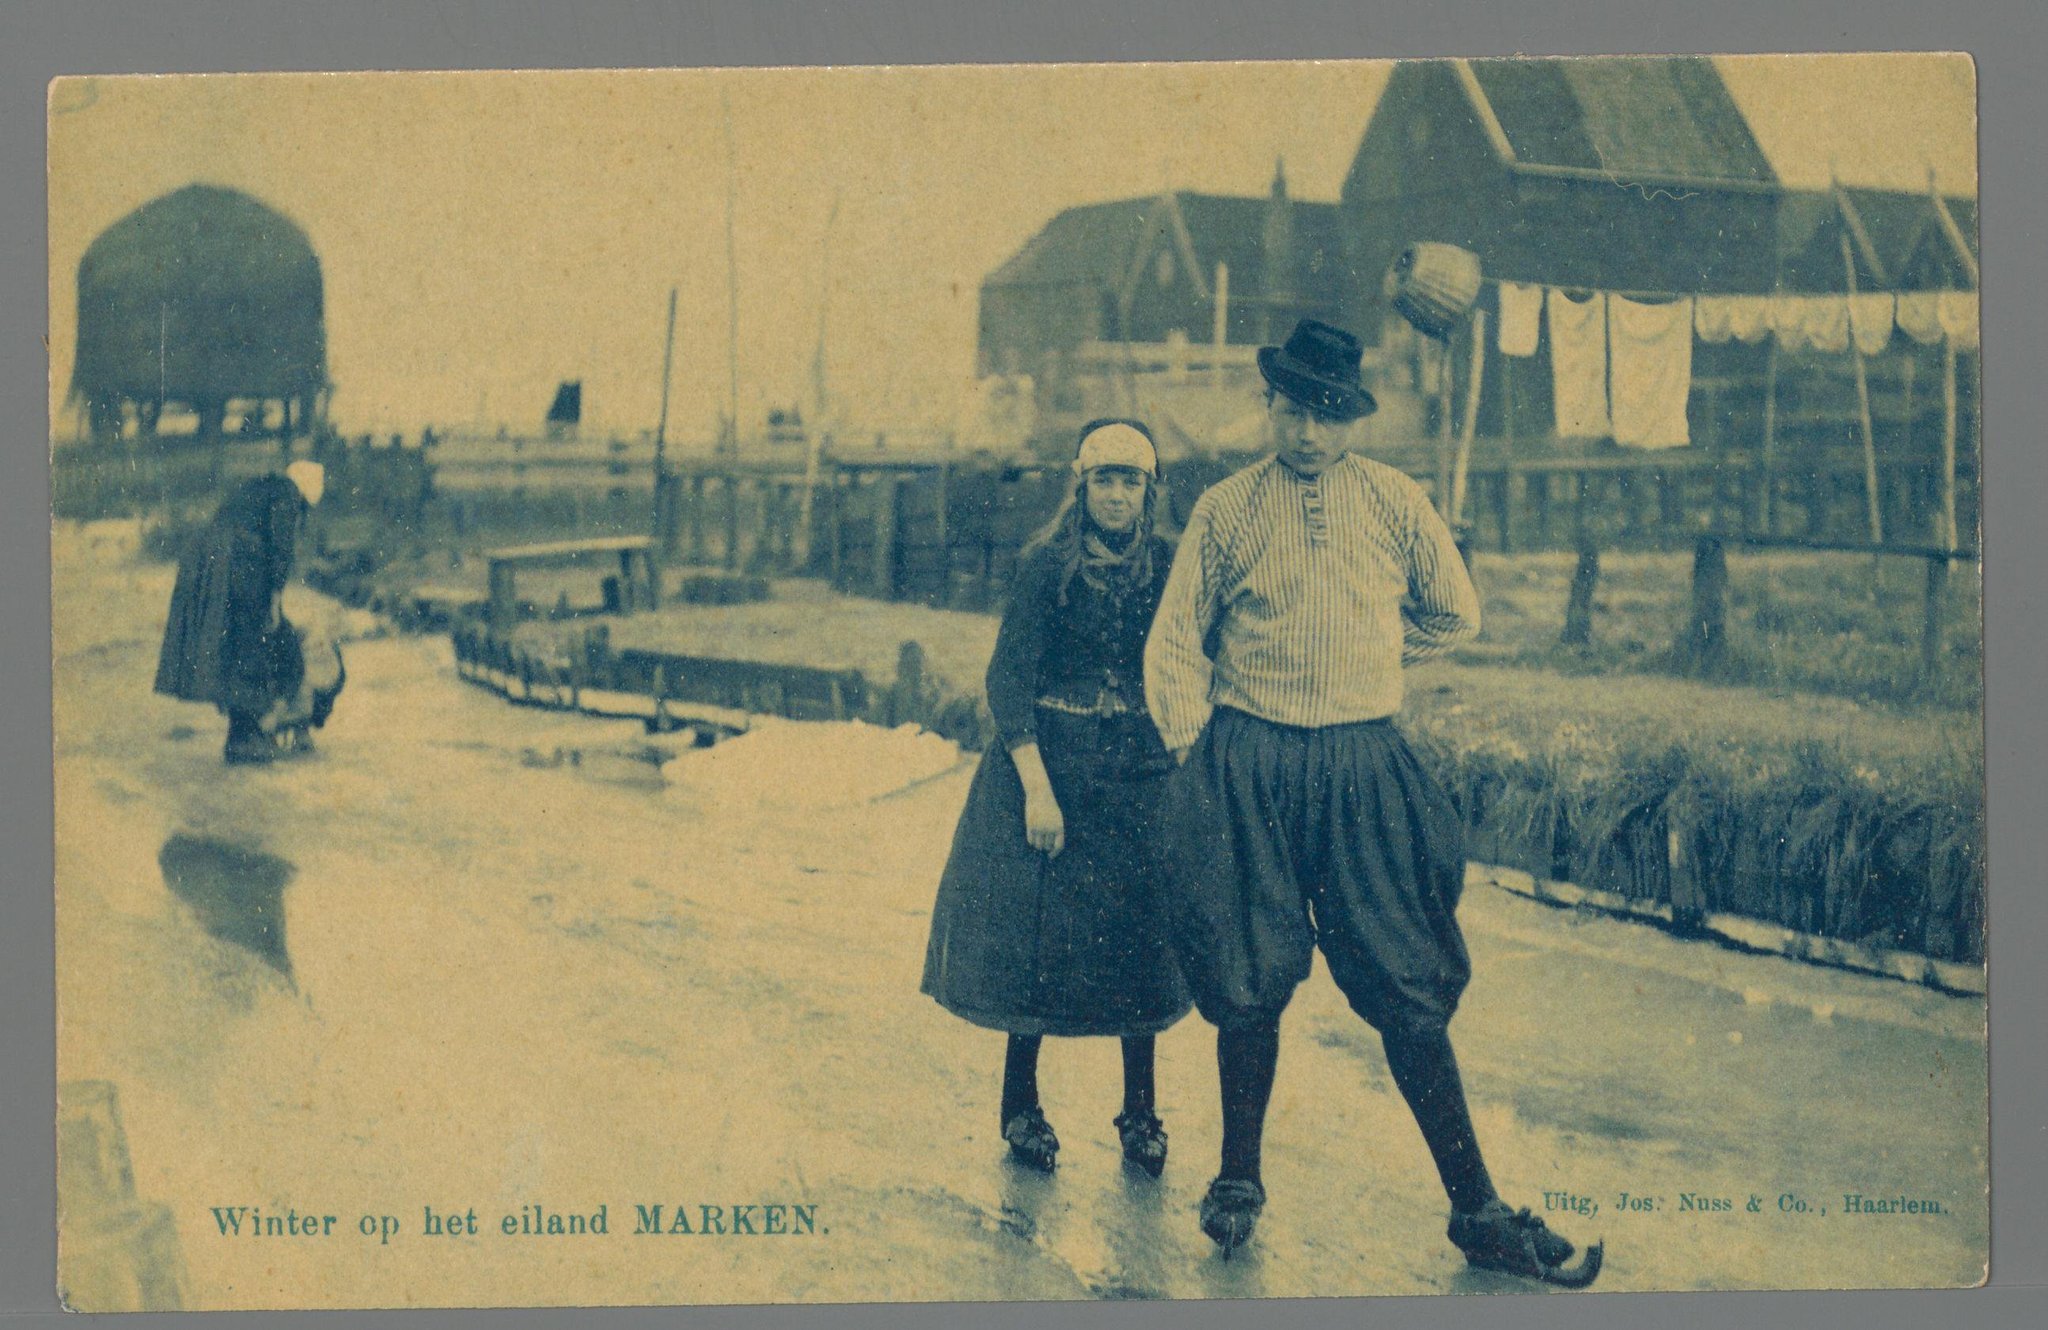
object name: ansichtkaart, prentbriefkaart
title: Winter op het eiland Marken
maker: Anonymous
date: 1906-1909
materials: cardboard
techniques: photograph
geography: marken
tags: historical persons, winter landscape; landscape symbolizing winter (the four seasons of the year), skates (winter sports), clothes, costume